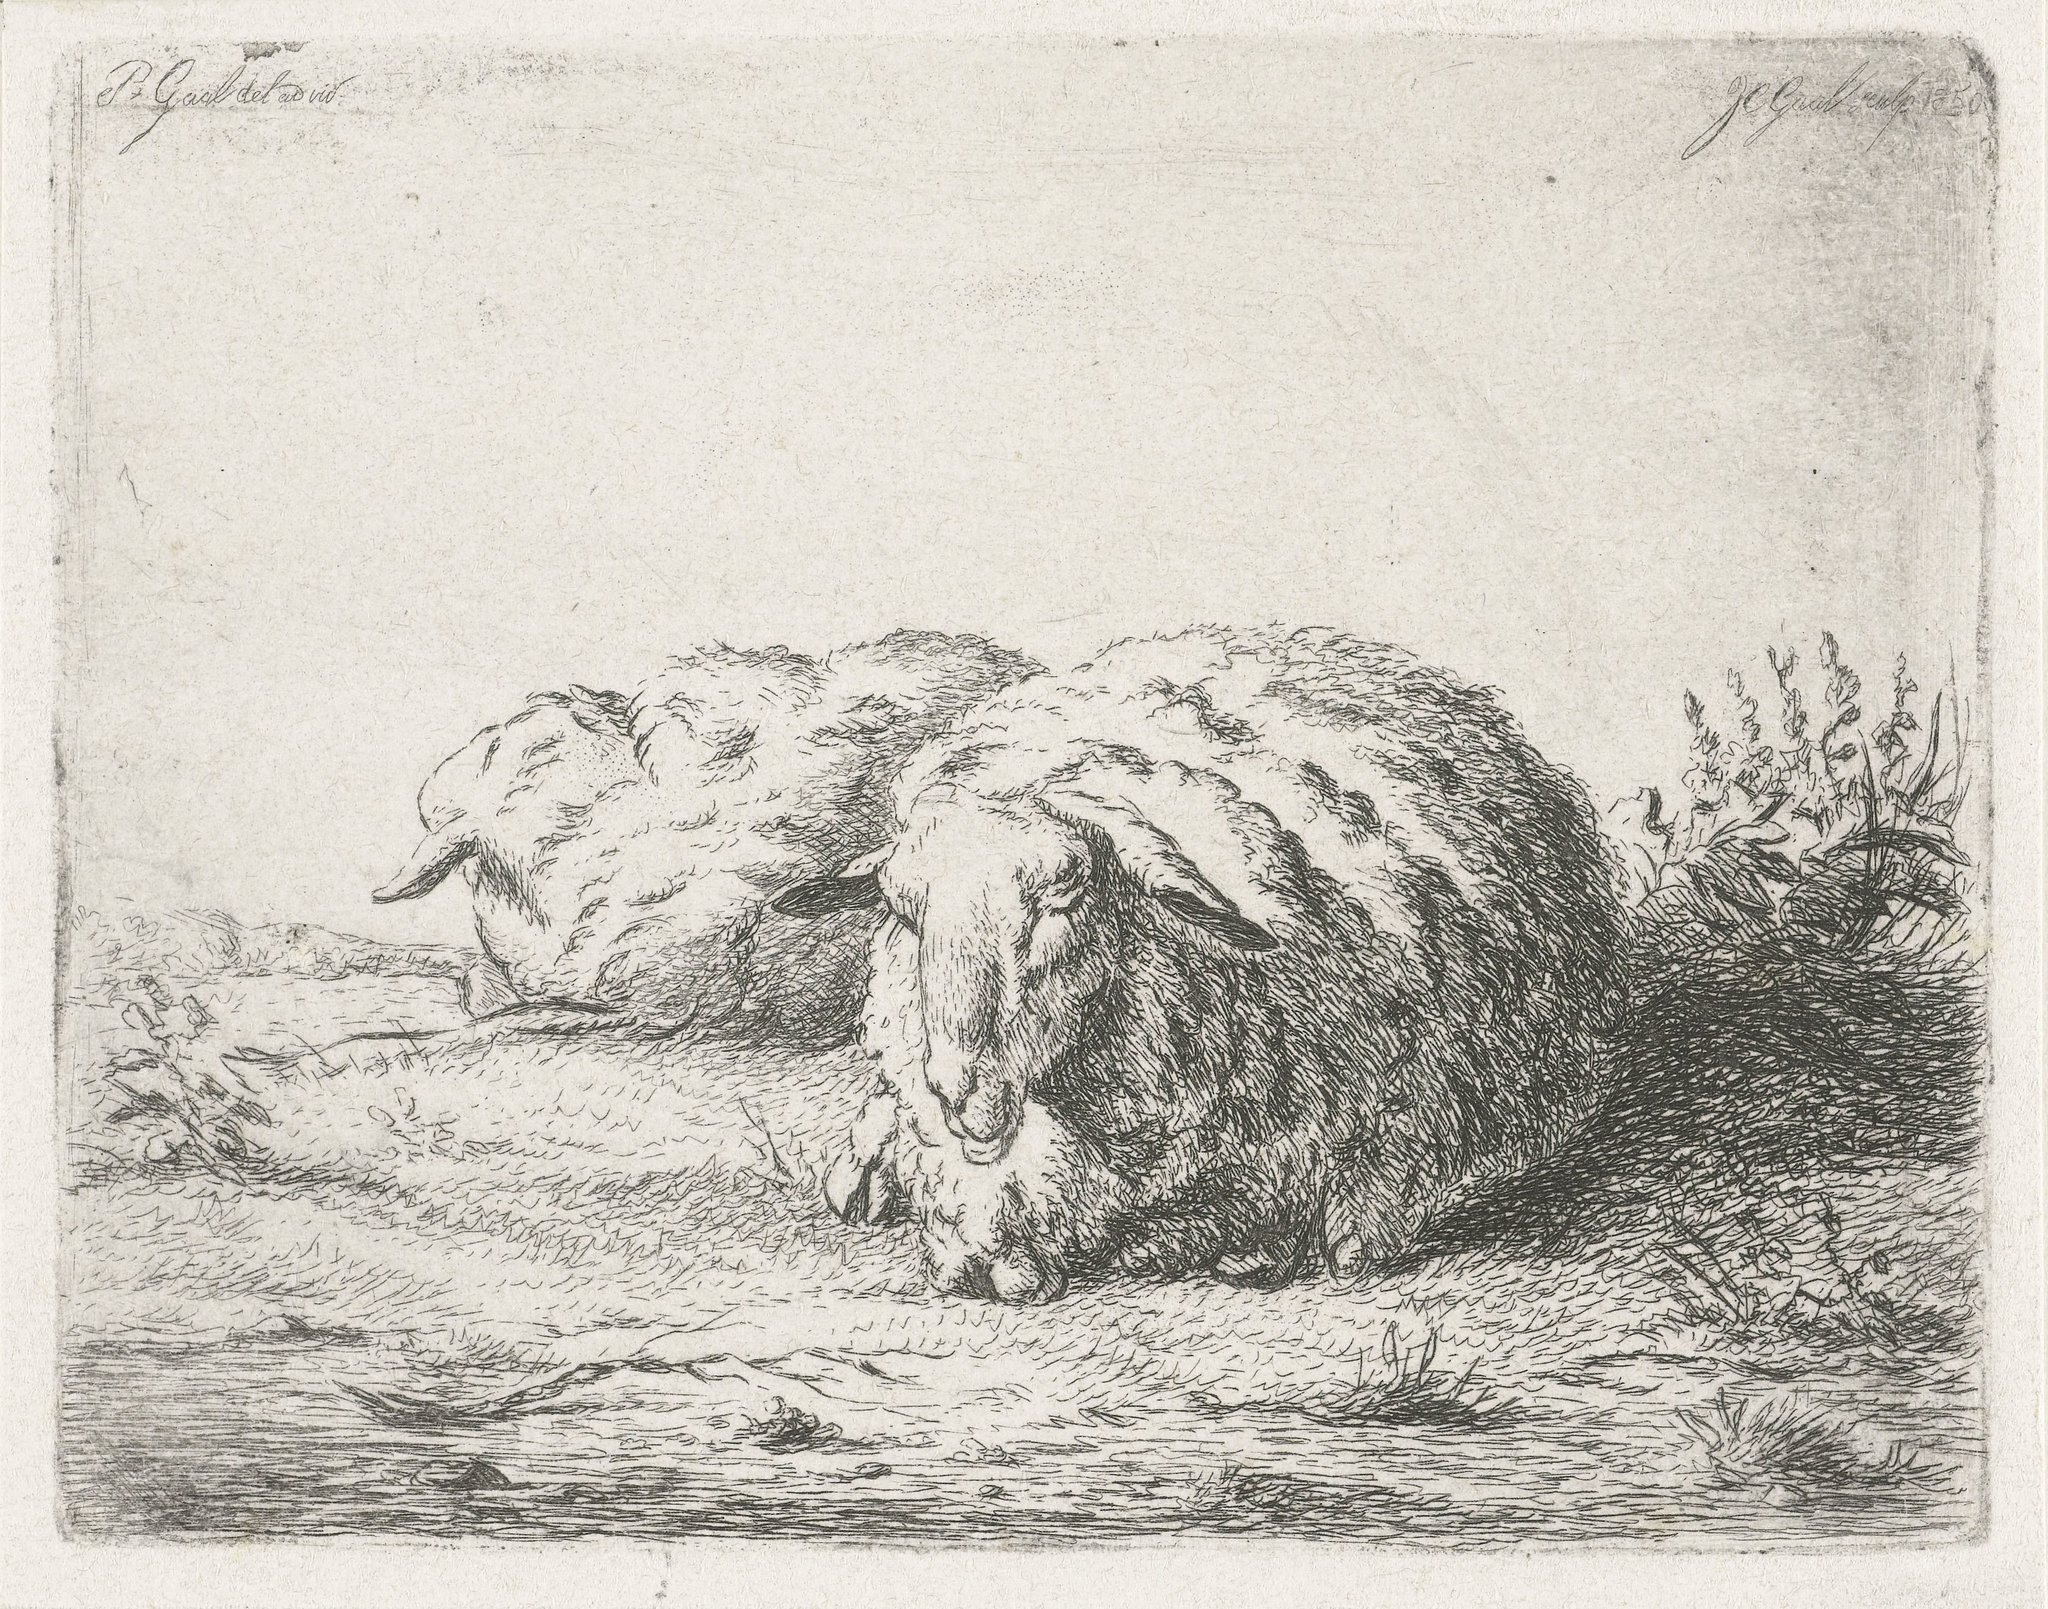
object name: print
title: Twee liggende schapen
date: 1850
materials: paper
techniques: etching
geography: netherlands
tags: sheep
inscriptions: collector's mark: Lugt 2228